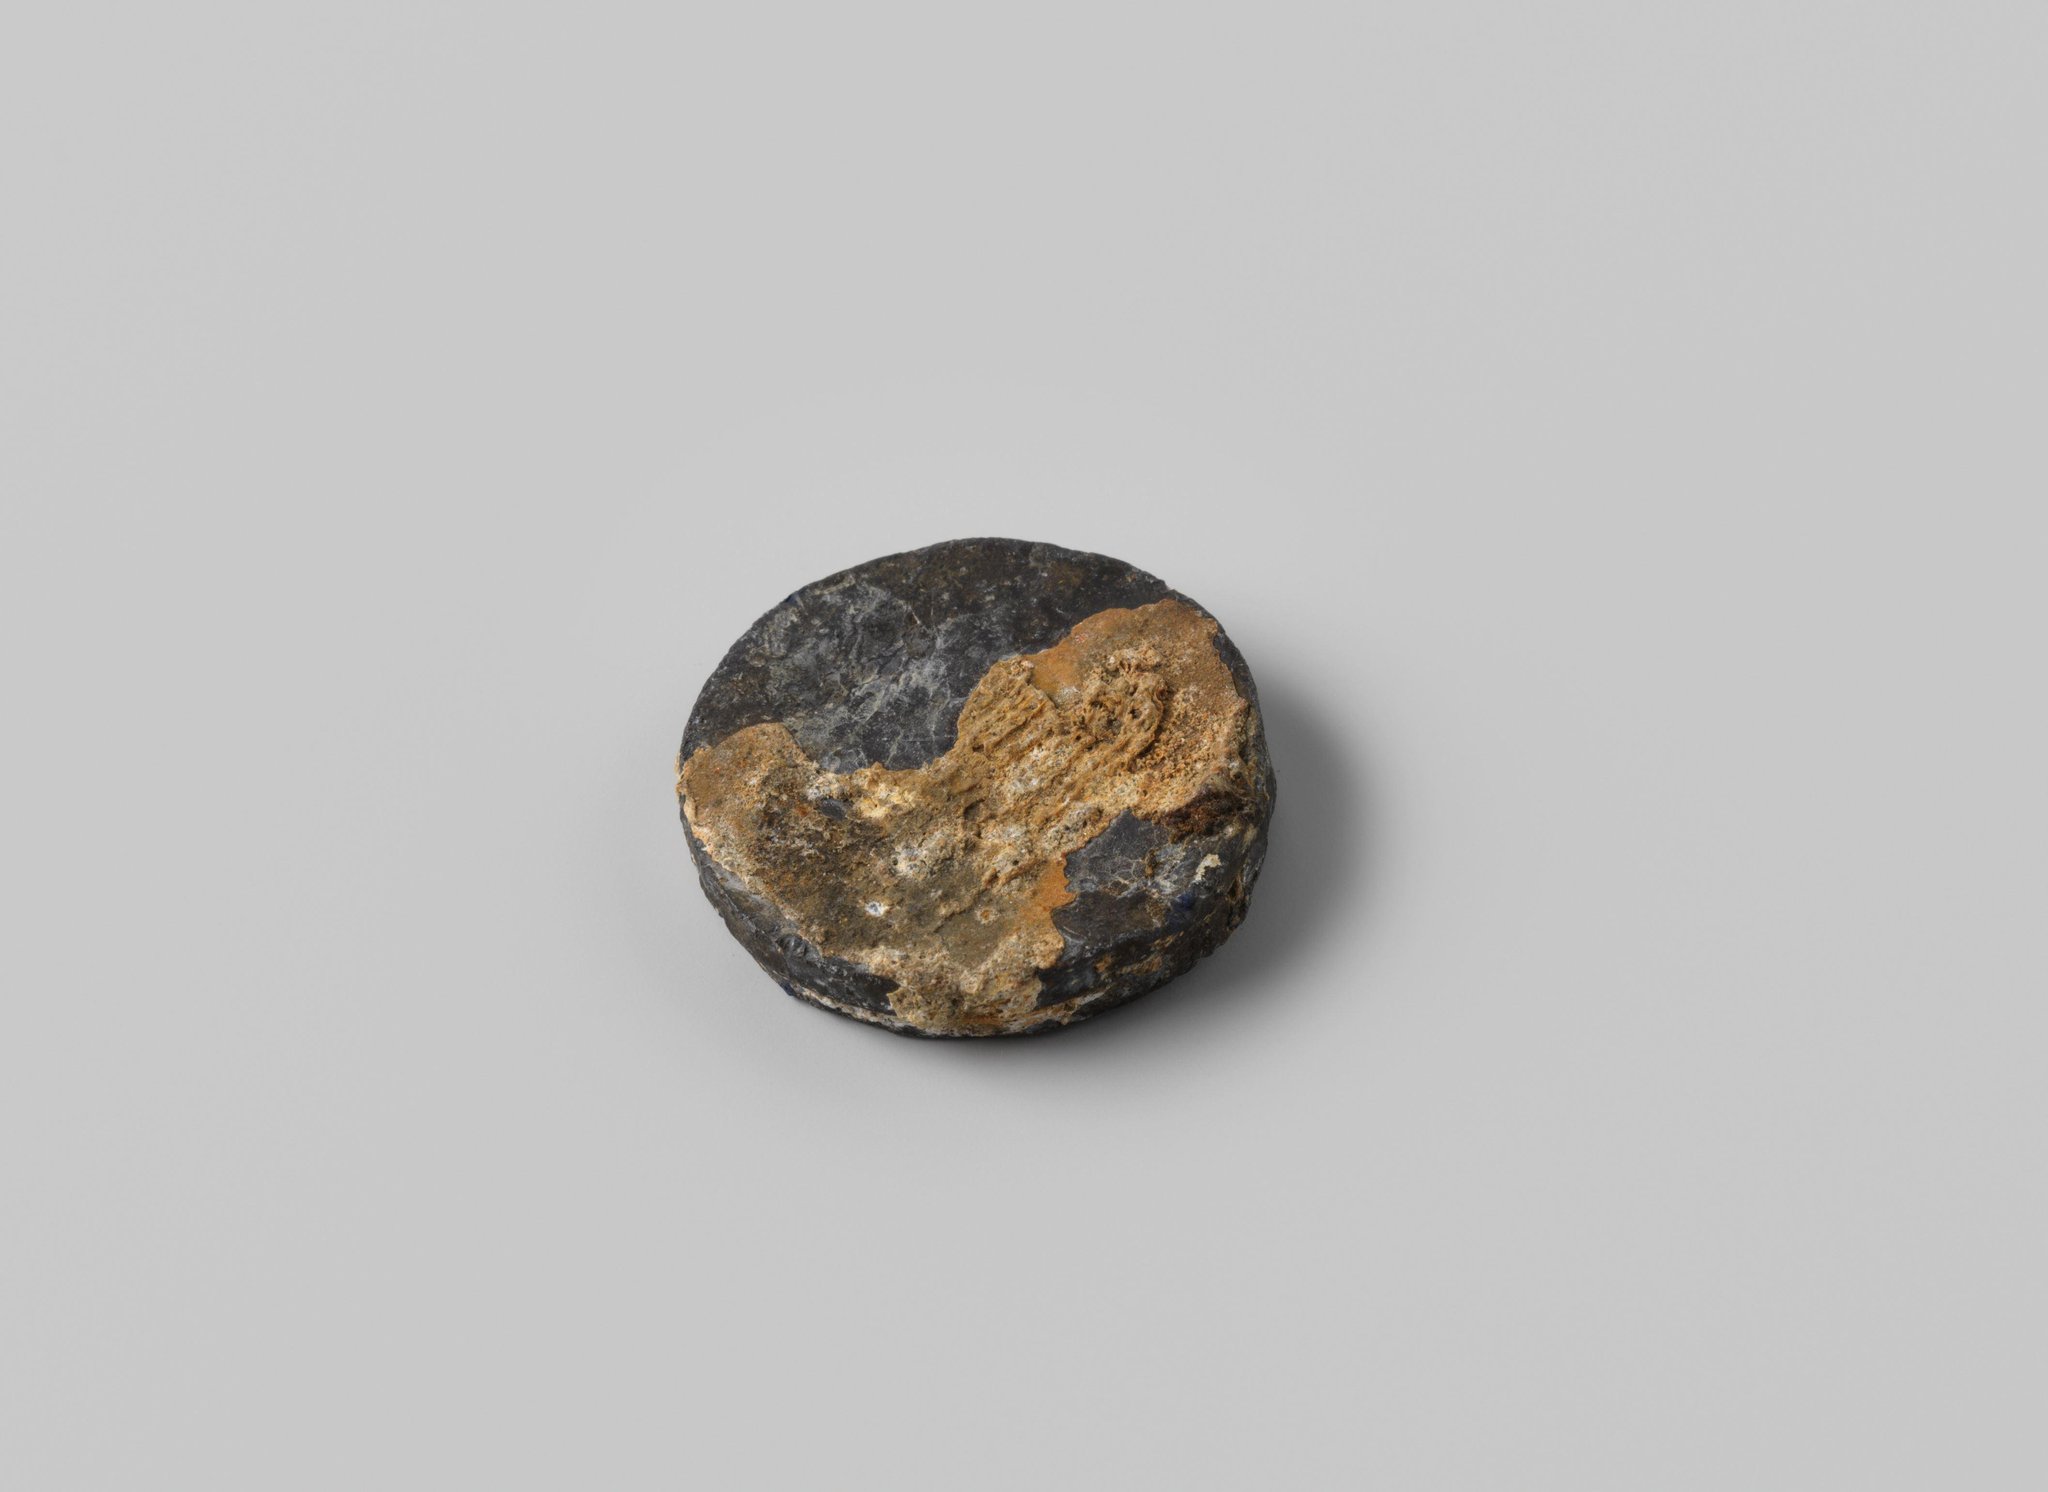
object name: gaming counter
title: Twee ronde aan elkaar gecorrodeerde speelpenningen uit het wrak van de Oost-Indiëvaarder Hollandia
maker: Anonymous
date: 1700-1743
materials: lead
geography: netherlands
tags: verenigde oostindische compagnie, hollandia (schip), annet